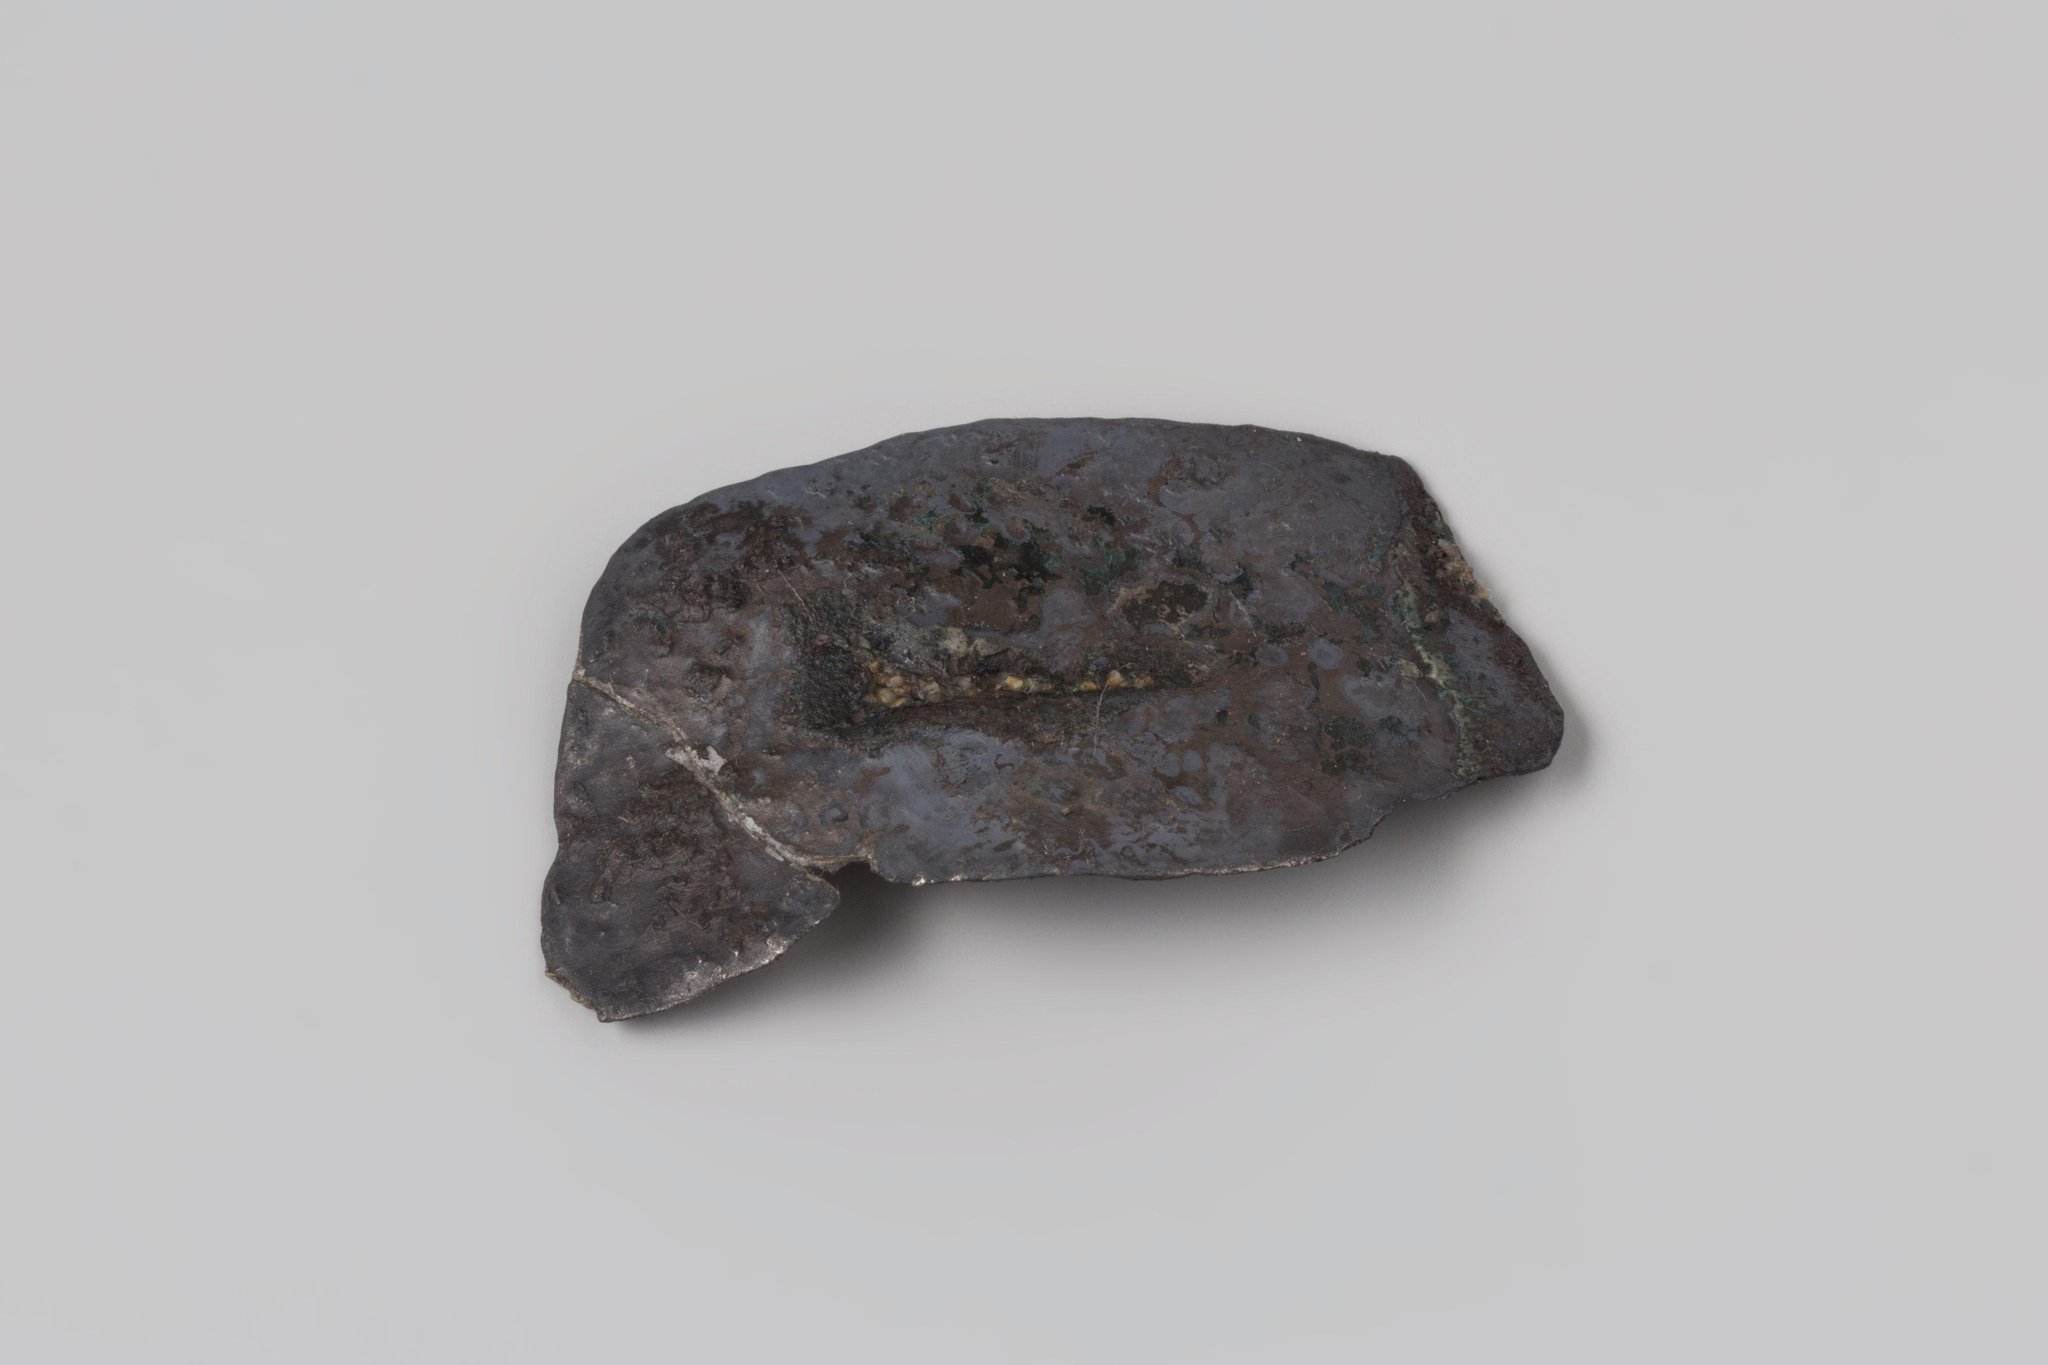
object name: scheepswrakvondst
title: Fragment van zilver uit het wrak van de Oost-Indiëvaarder Hollandia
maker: Anonymous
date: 1700-1743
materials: silver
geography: netherlands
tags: verenigde oostindische compagnie, hollandia (schip), annet